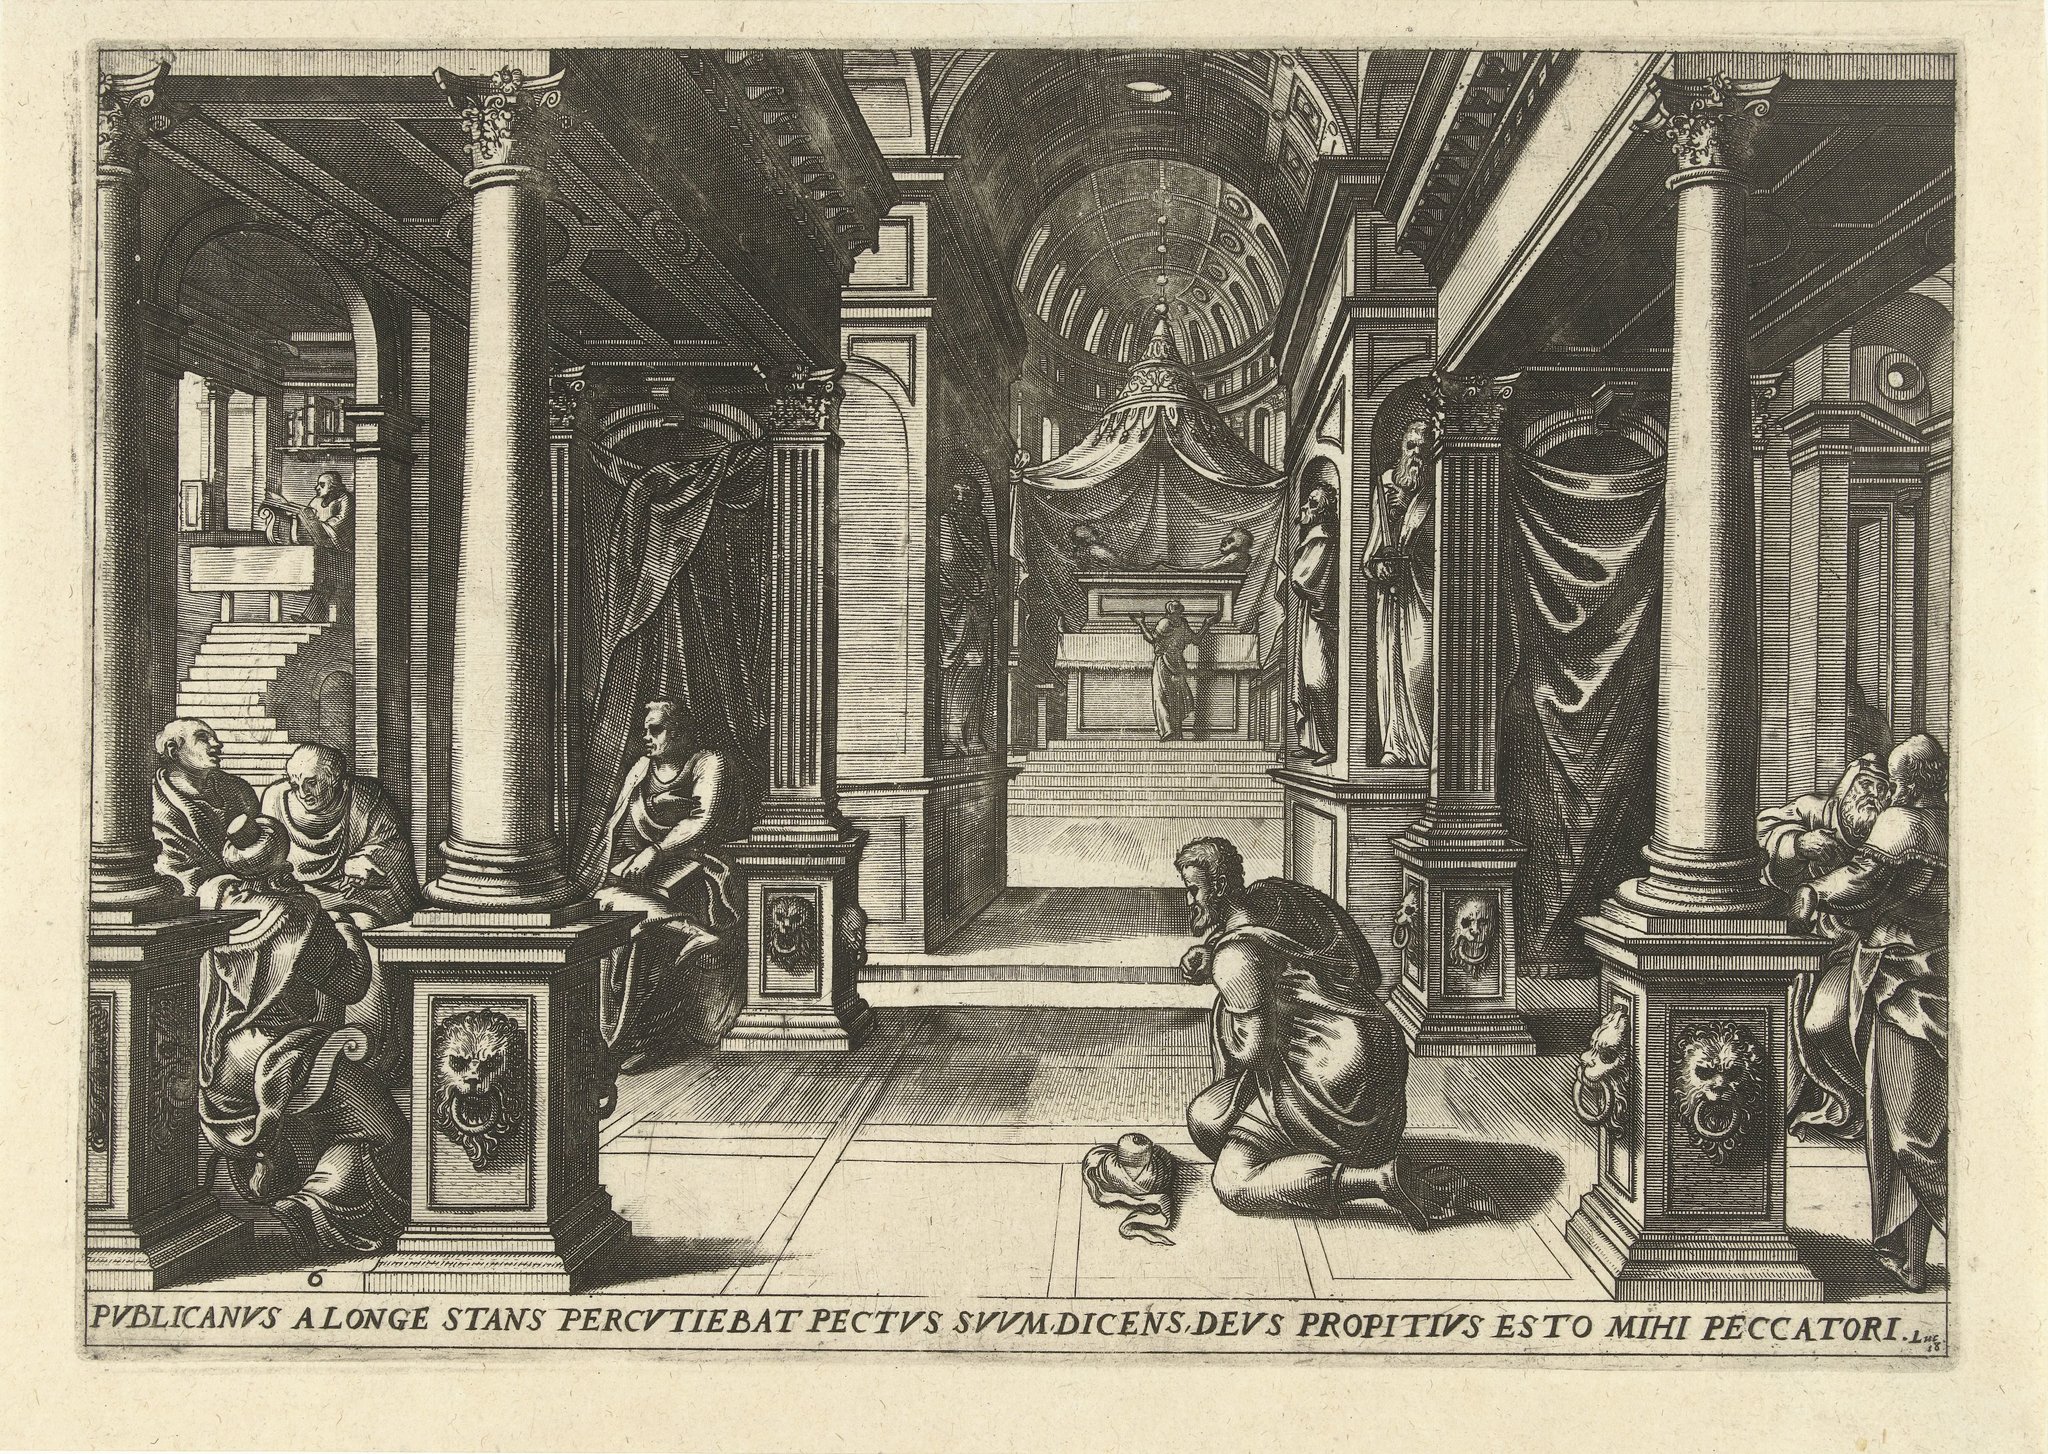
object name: print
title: Memorabilivm Novi Testamenti in templo gestorvm icones tredecim elegantissimi ac ornatissimi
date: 1572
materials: paper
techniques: engraving, etching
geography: antwerp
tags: the praying pharisee and the repentant publican in the temple (luke 18:10-14)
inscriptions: collector's mark: Lugt 2760, collector's mark: Lugt 2228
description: Een farizeër bidt in de tempel bij het altaar. Op de voorgrond kniëlt een tollenaar. Hij durft niet dichtbij te komen en vraagt God om vergiffenis van zijn zonden. In de zijbeuken van de tempel zijn mensen druk in gesprek.